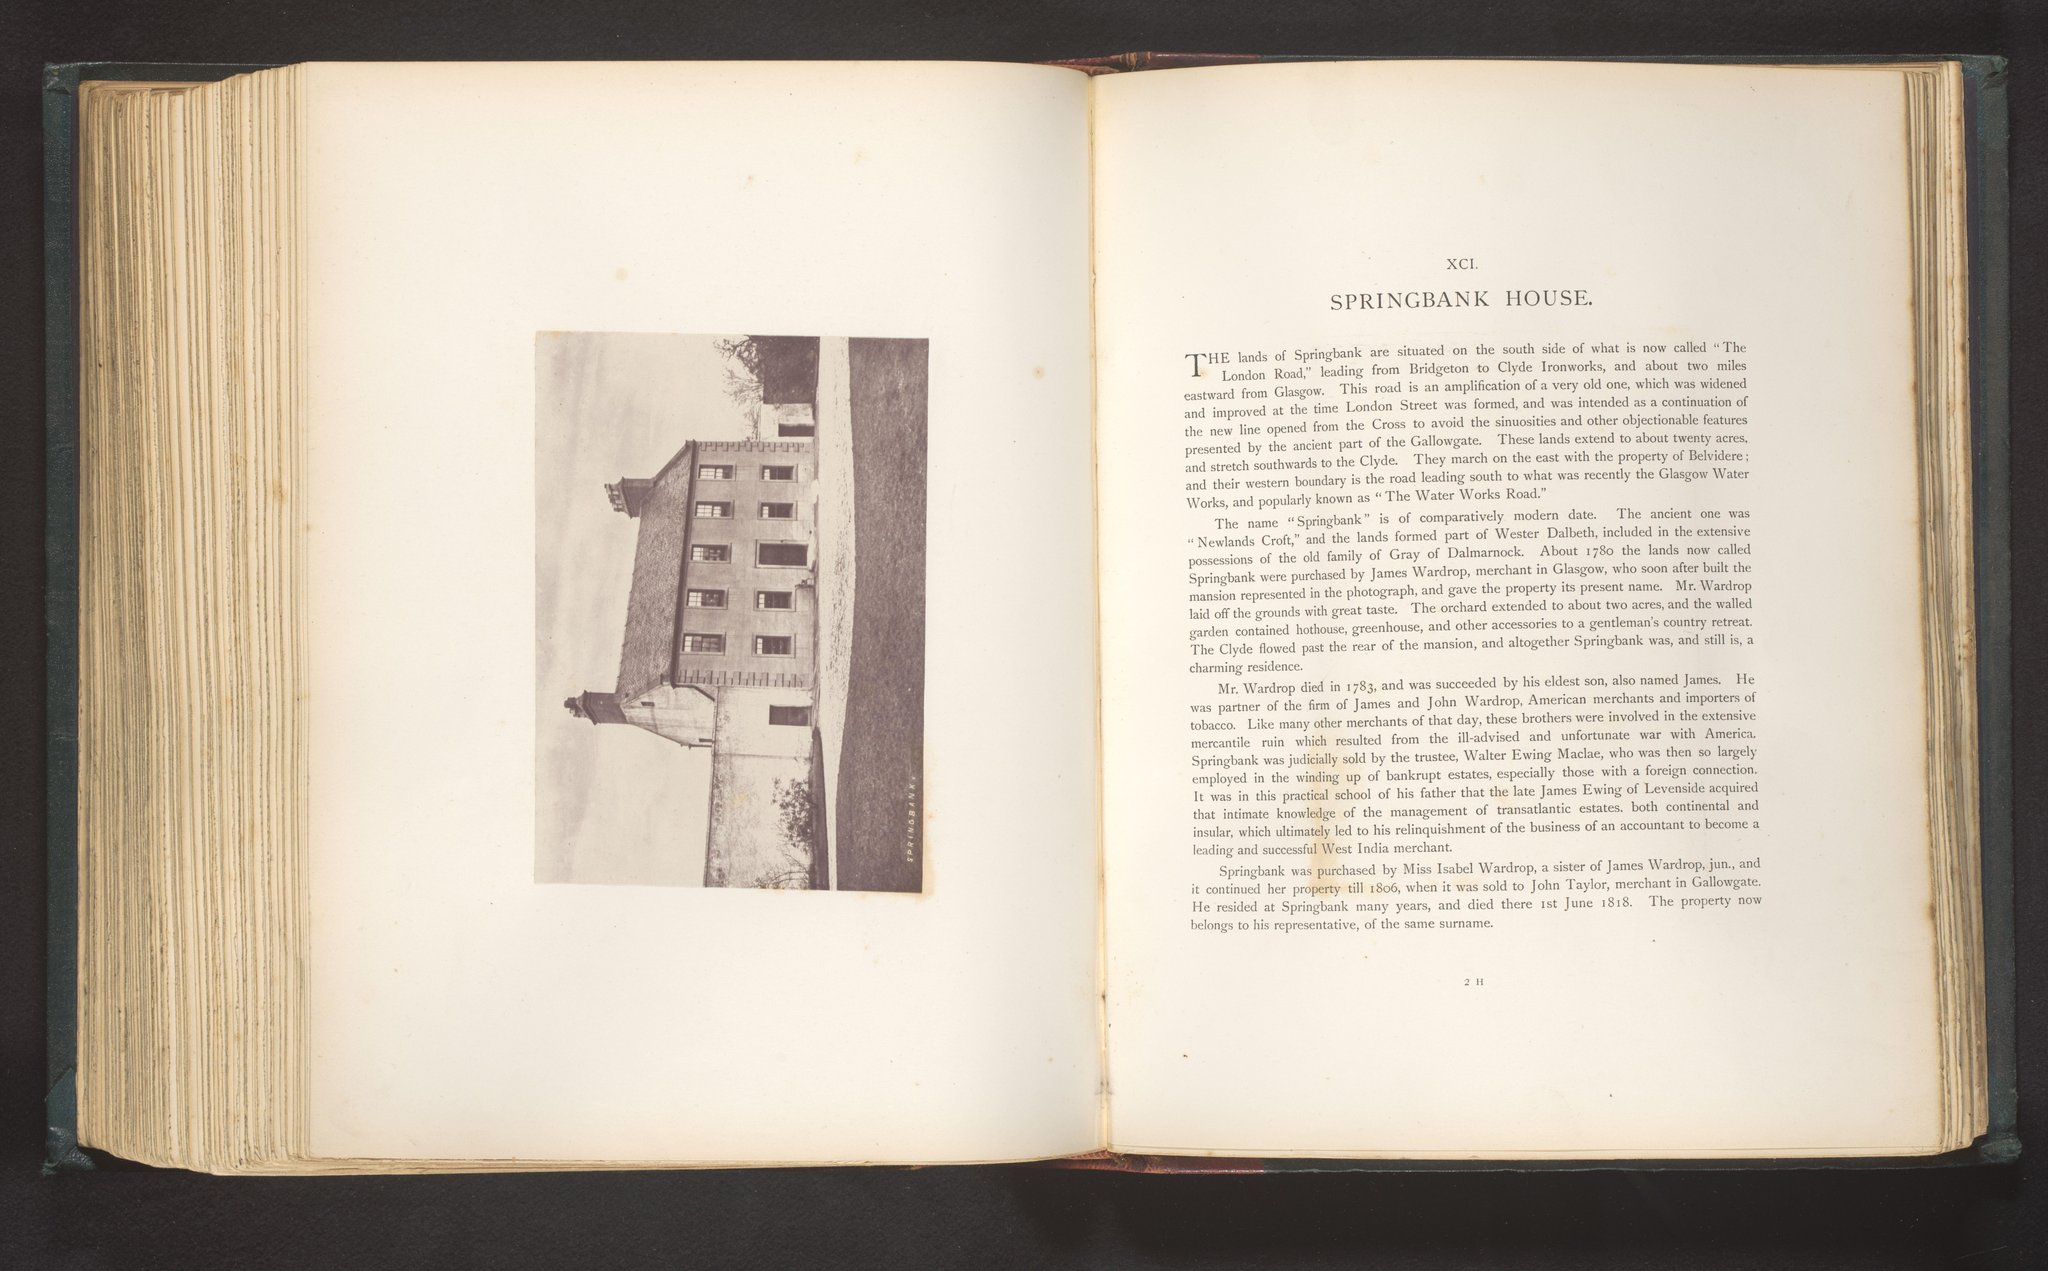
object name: page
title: Springbank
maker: thomas annan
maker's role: fotograaf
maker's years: 1829-1887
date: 1868-1878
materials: paper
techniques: carbon print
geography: glasgow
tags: rural housing, e.g. country-house, villa, cottage, façade (of house or building)